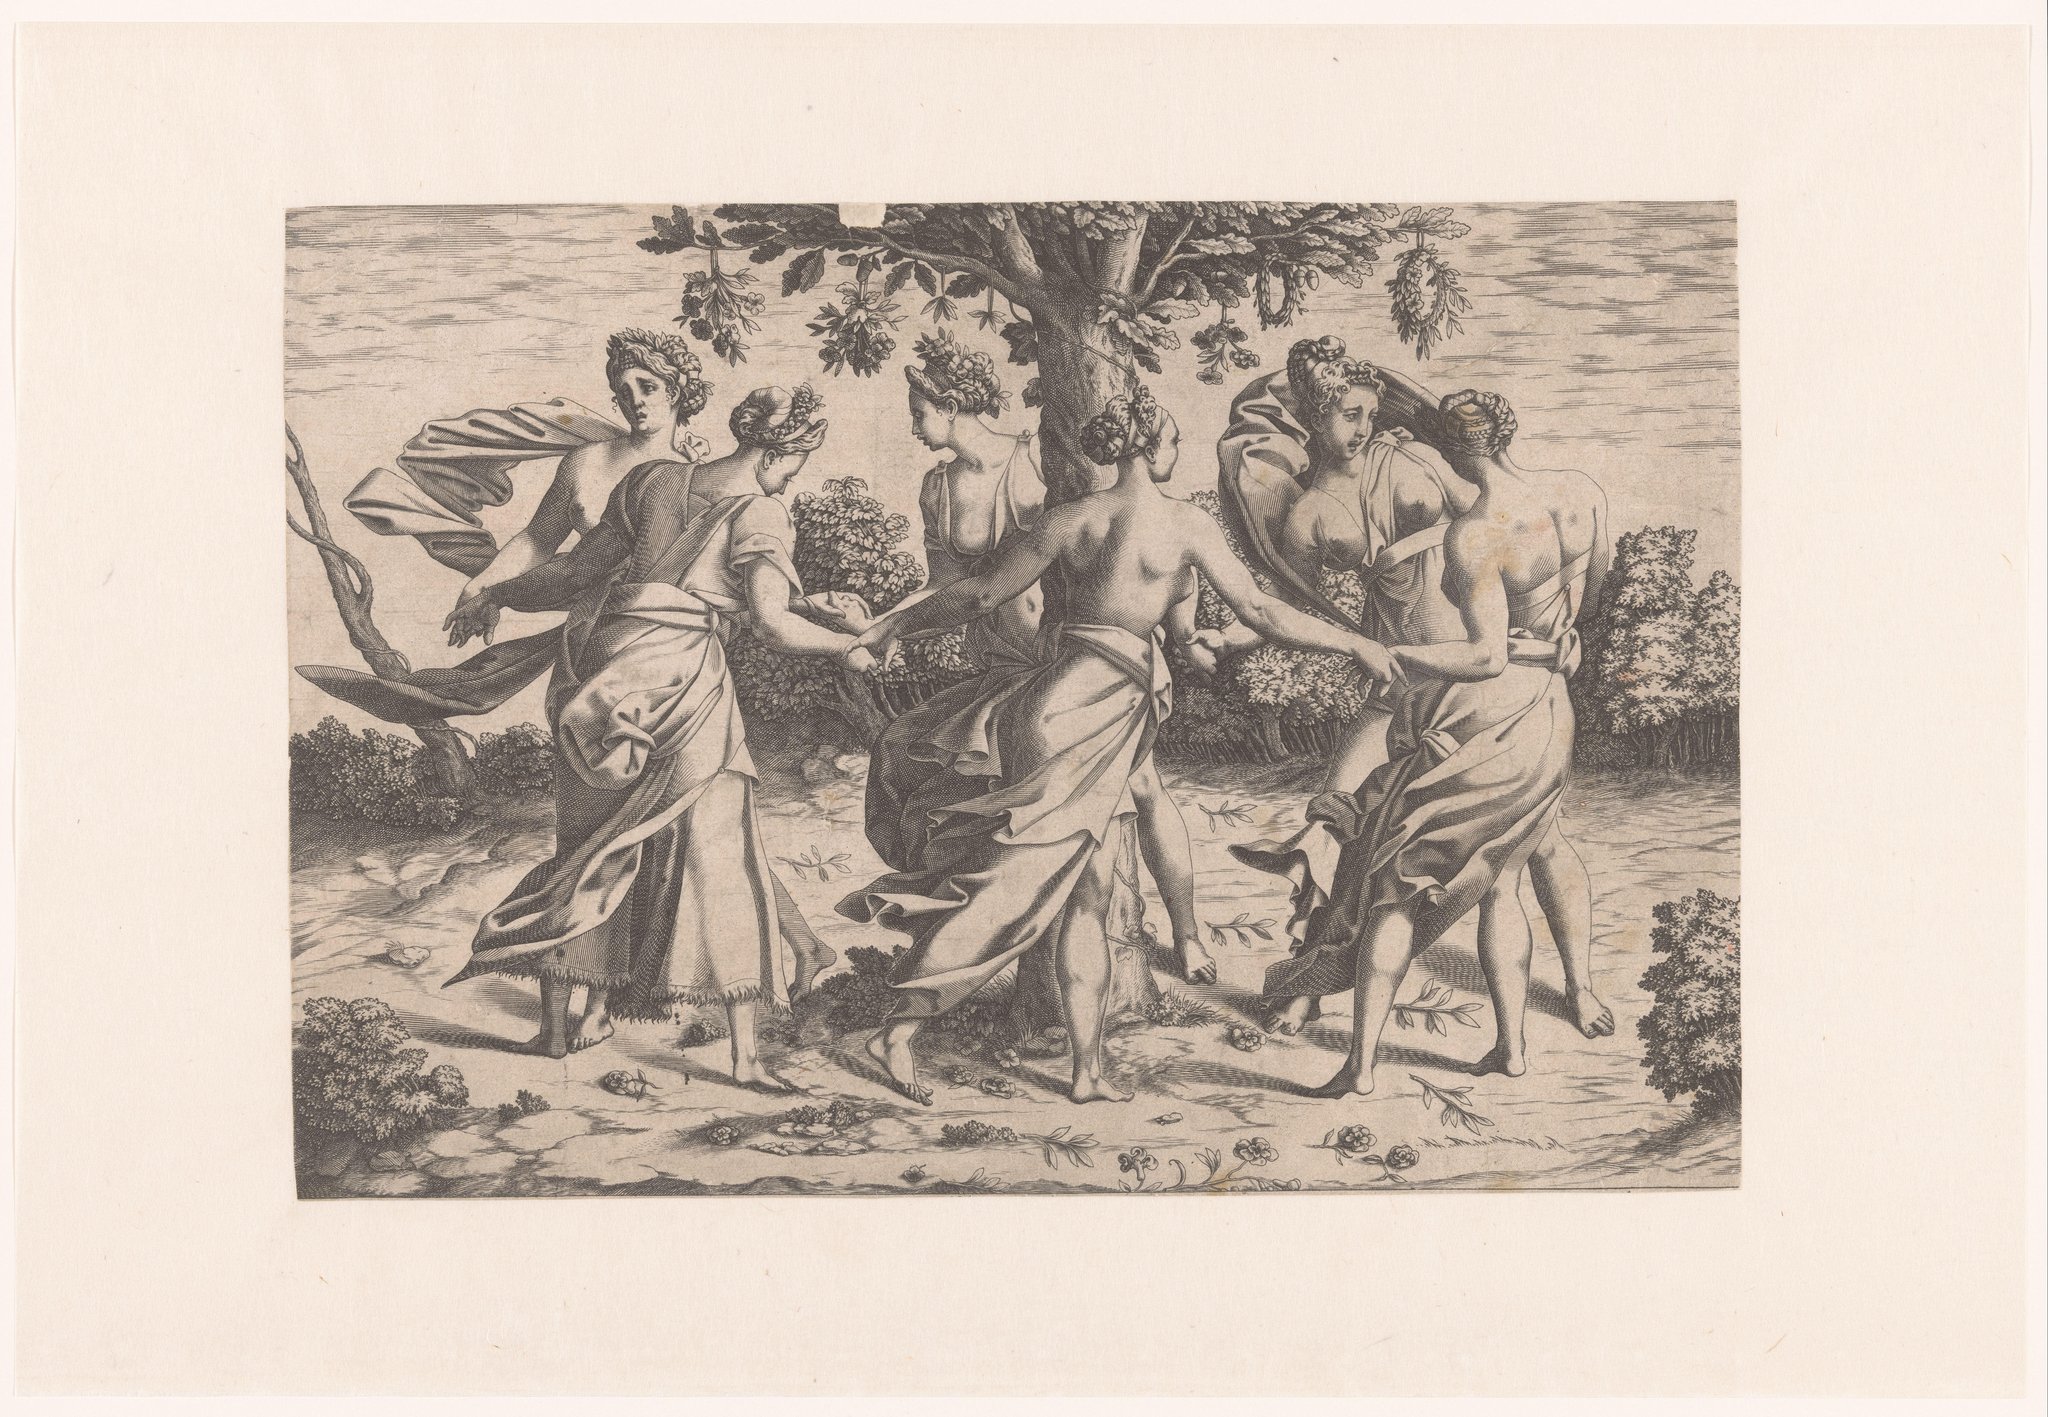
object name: print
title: Dans van Driaden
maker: pierre milan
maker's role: print maker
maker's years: 1500-1557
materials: paper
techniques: engraving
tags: (hama)dryads, forest- and tree-nymphs; 'driadi & hamadriadi' (ripa)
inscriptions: collector's mark: Lugt 240